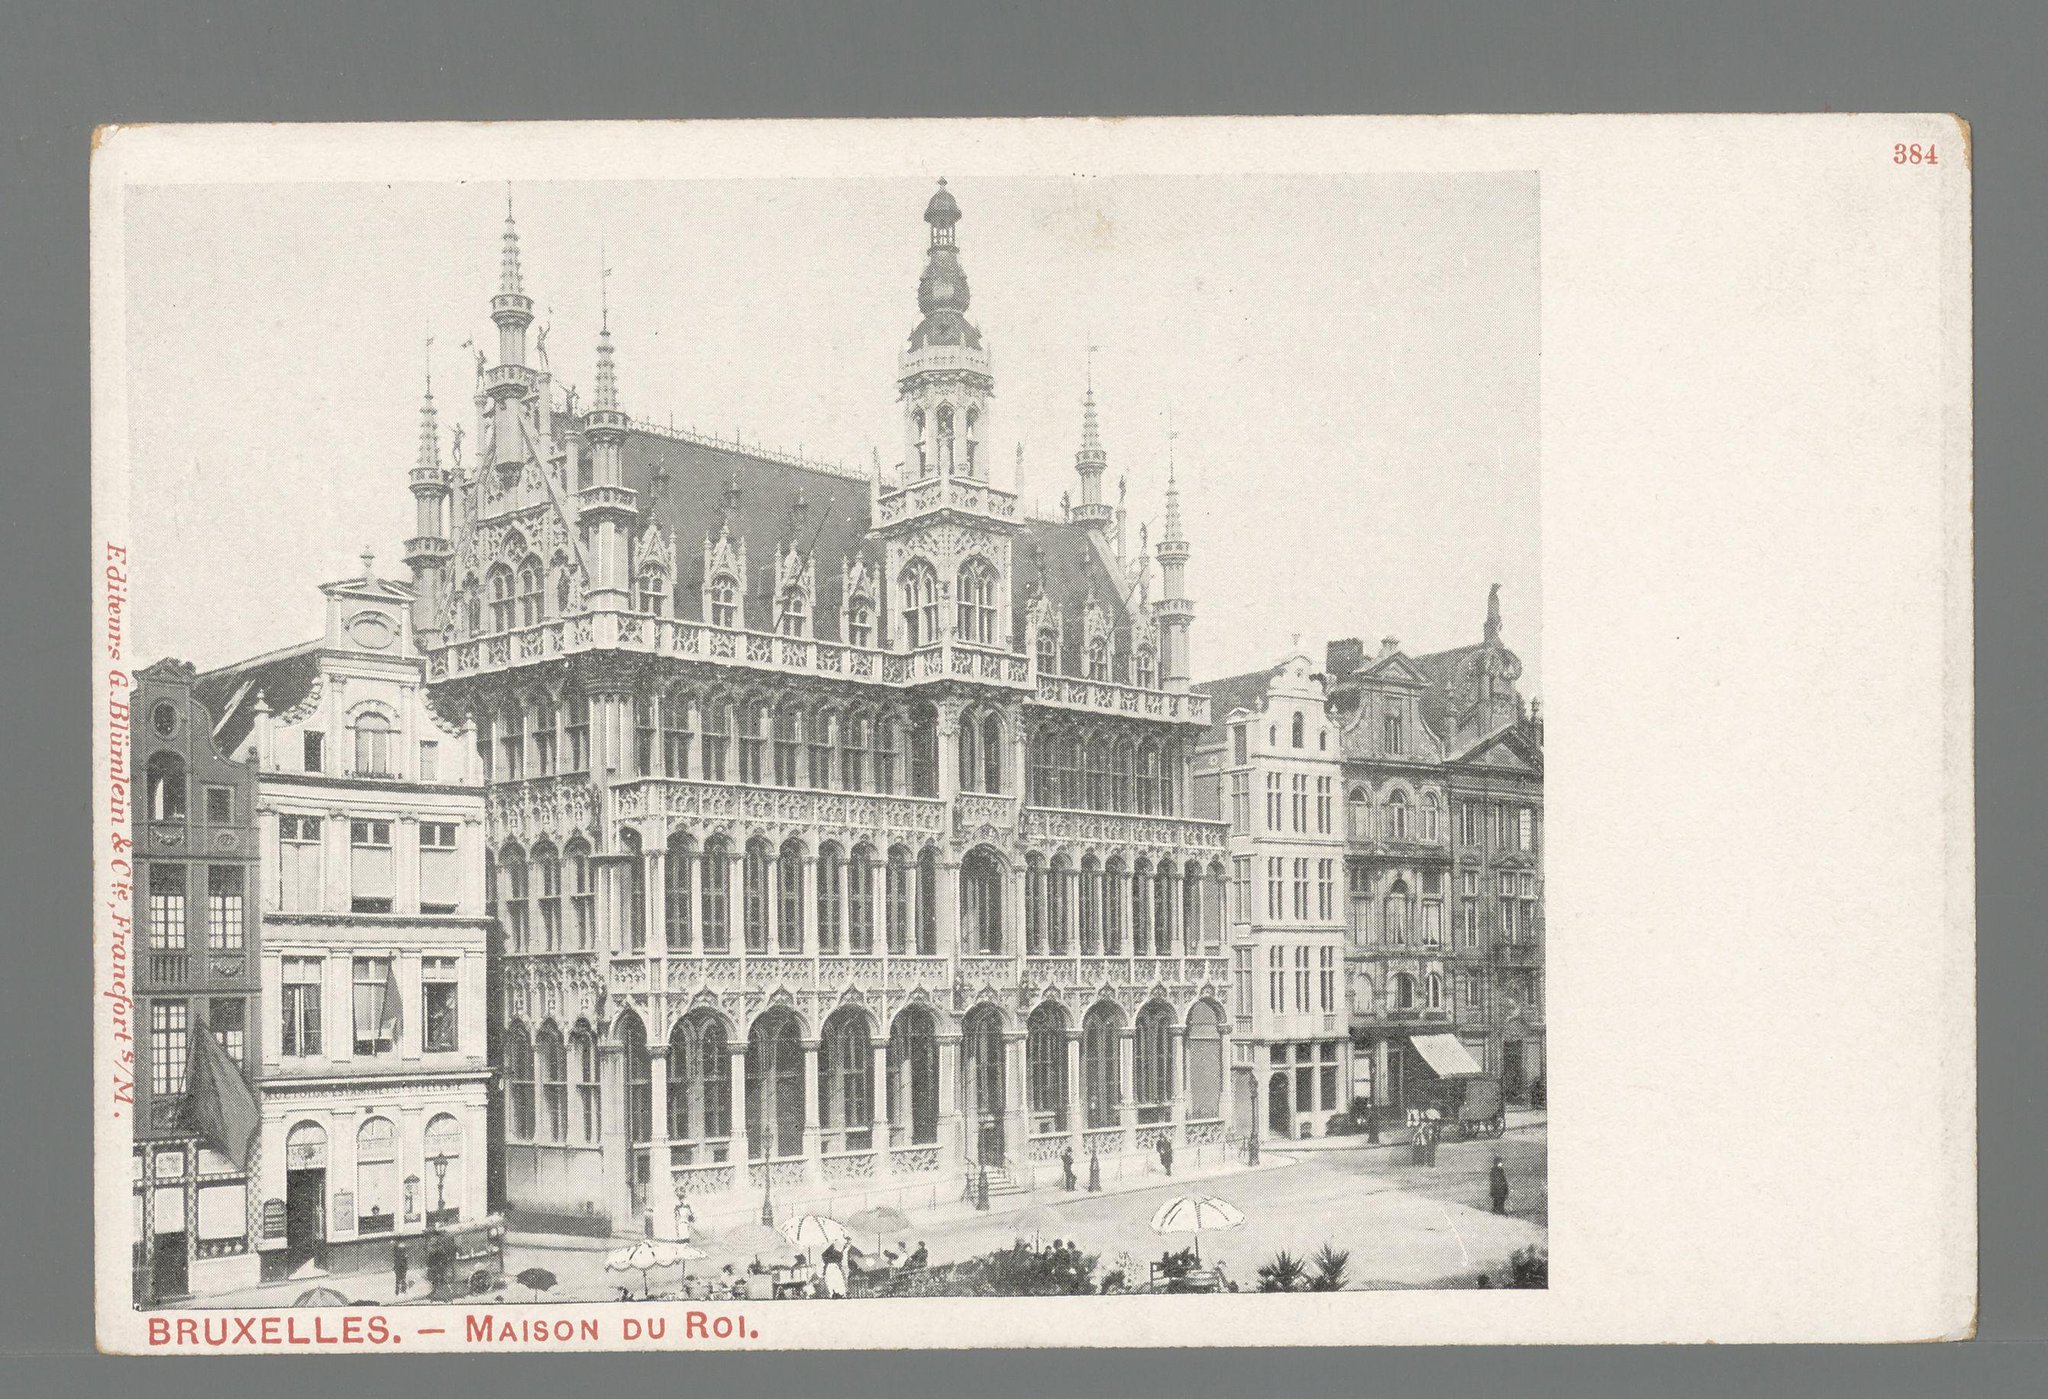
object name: photomechanical print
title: Bruxelles. Maison du Roi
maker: Anonymous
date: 1894-1906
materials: cardboard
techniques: autotype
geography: frankfurt am main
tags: square, place, circus, etc., city-view, and landscape with man-made constructions (+ city(-scape) with figures, staffage), edifice, e.g.: public building, department store